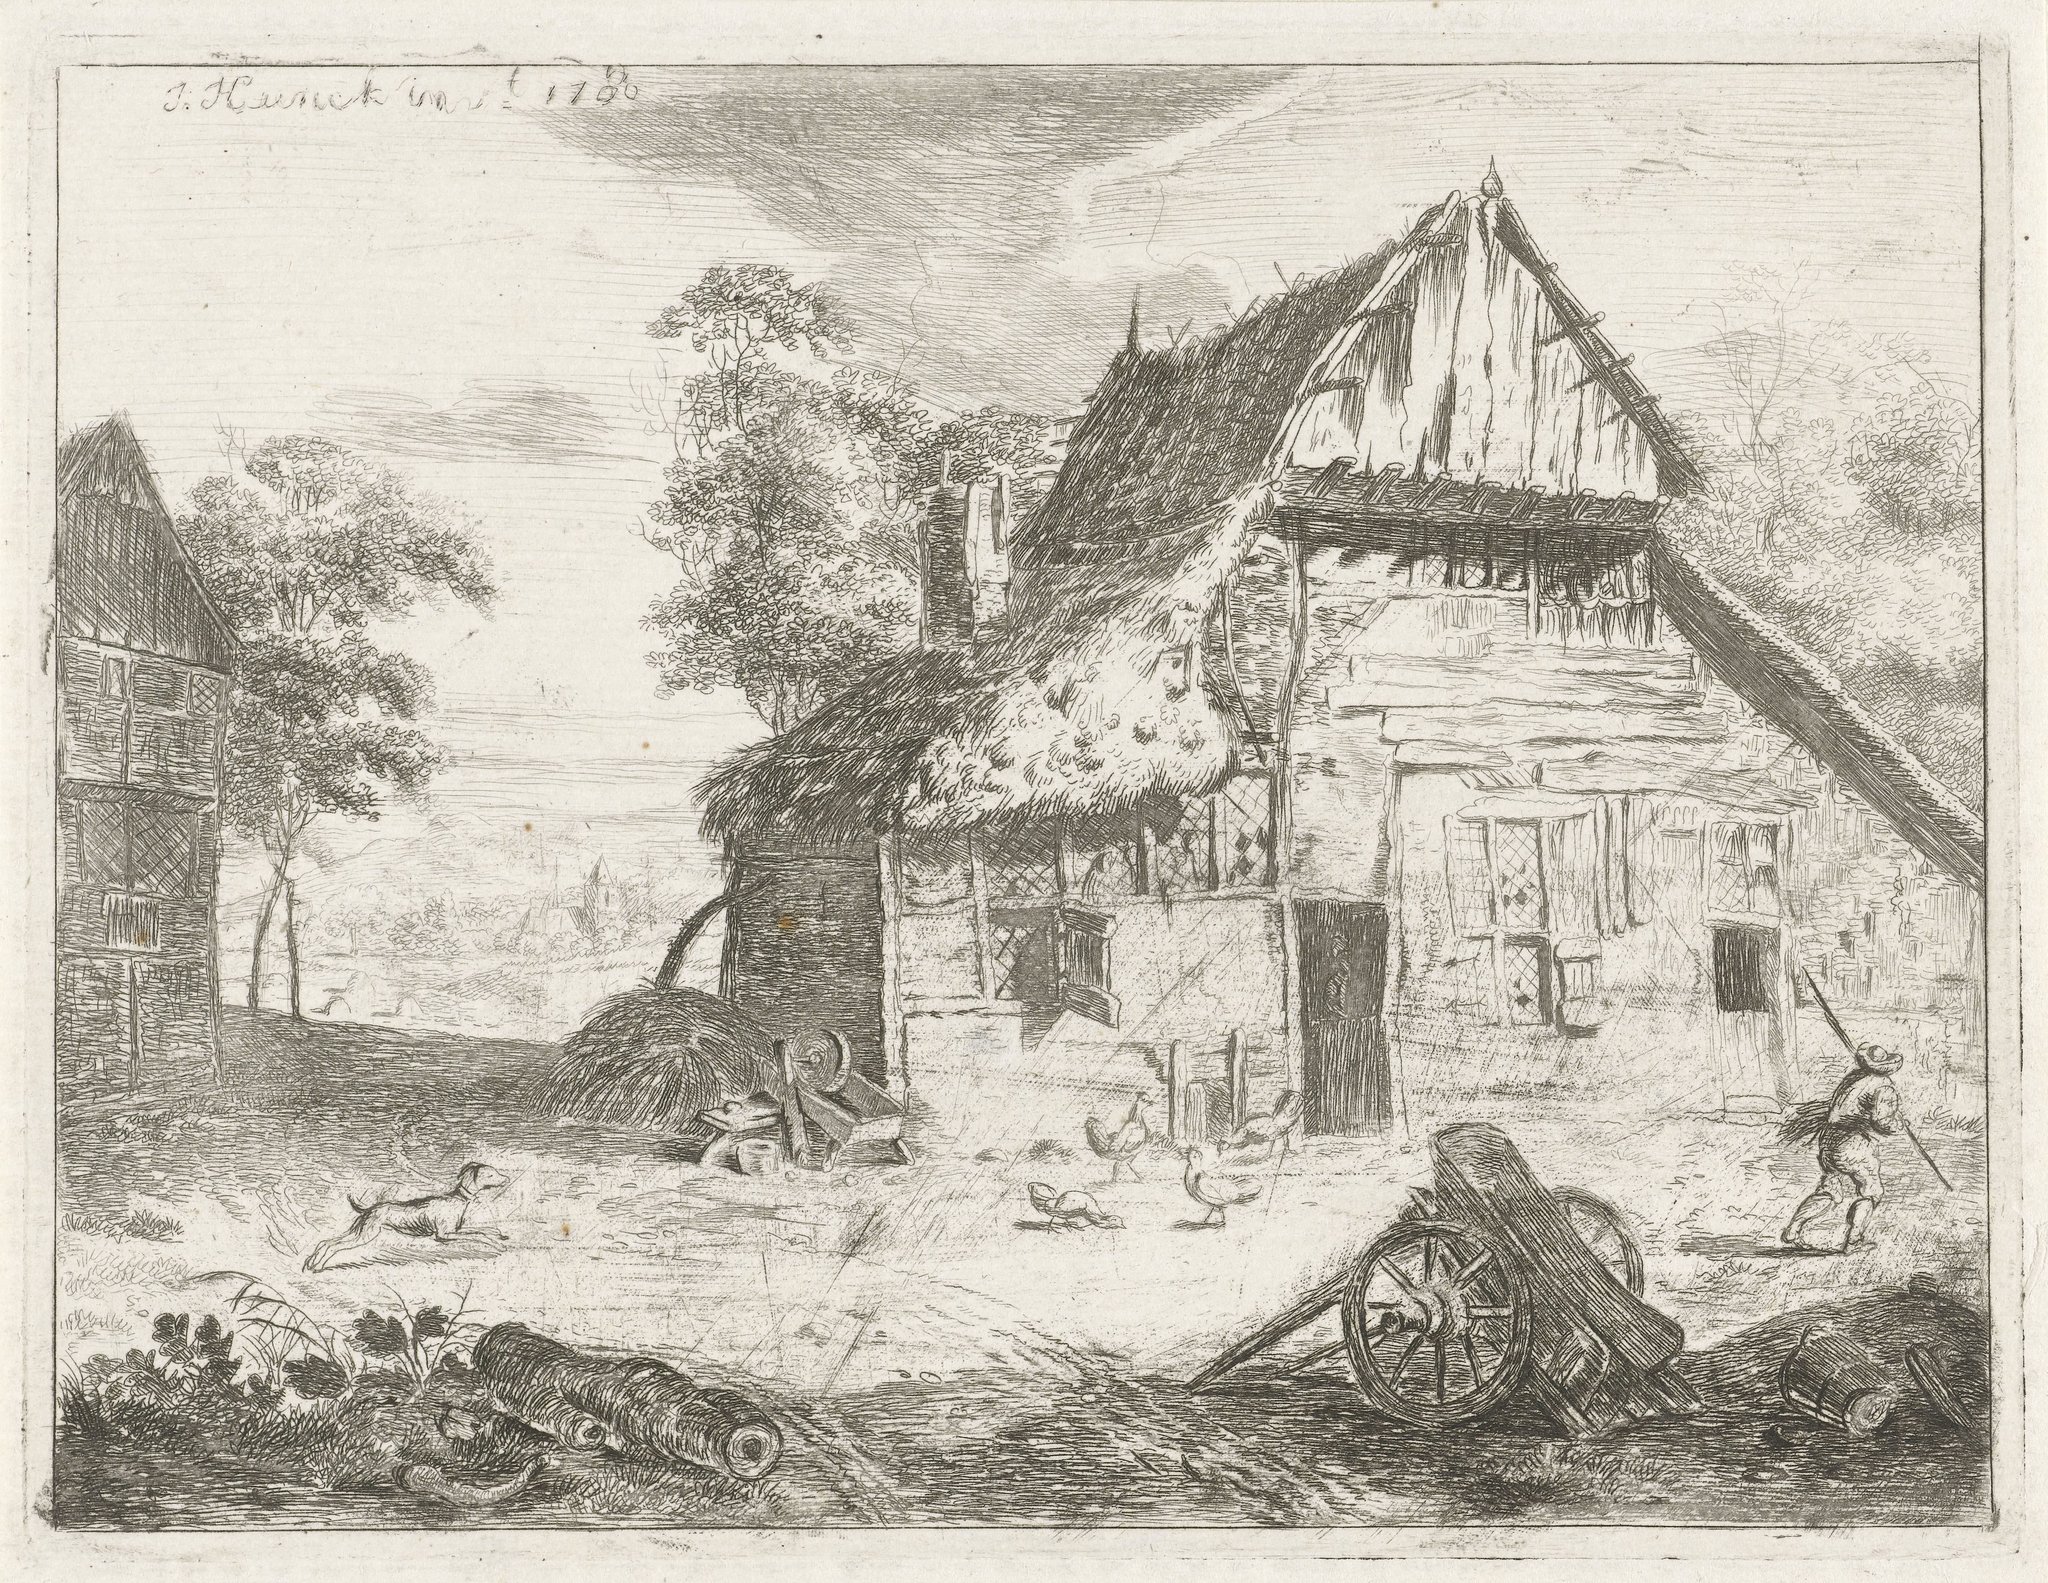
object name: print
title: Boerderij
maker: jabes heenck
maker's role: draughtsman, print maker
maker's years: 1752-1782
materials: paper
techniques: etching, roulette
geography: northern netherlands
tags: farm or solitary house in landscape (+ city(-scape) with figures, staffage)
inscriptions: collector's mark: Lugt 2228